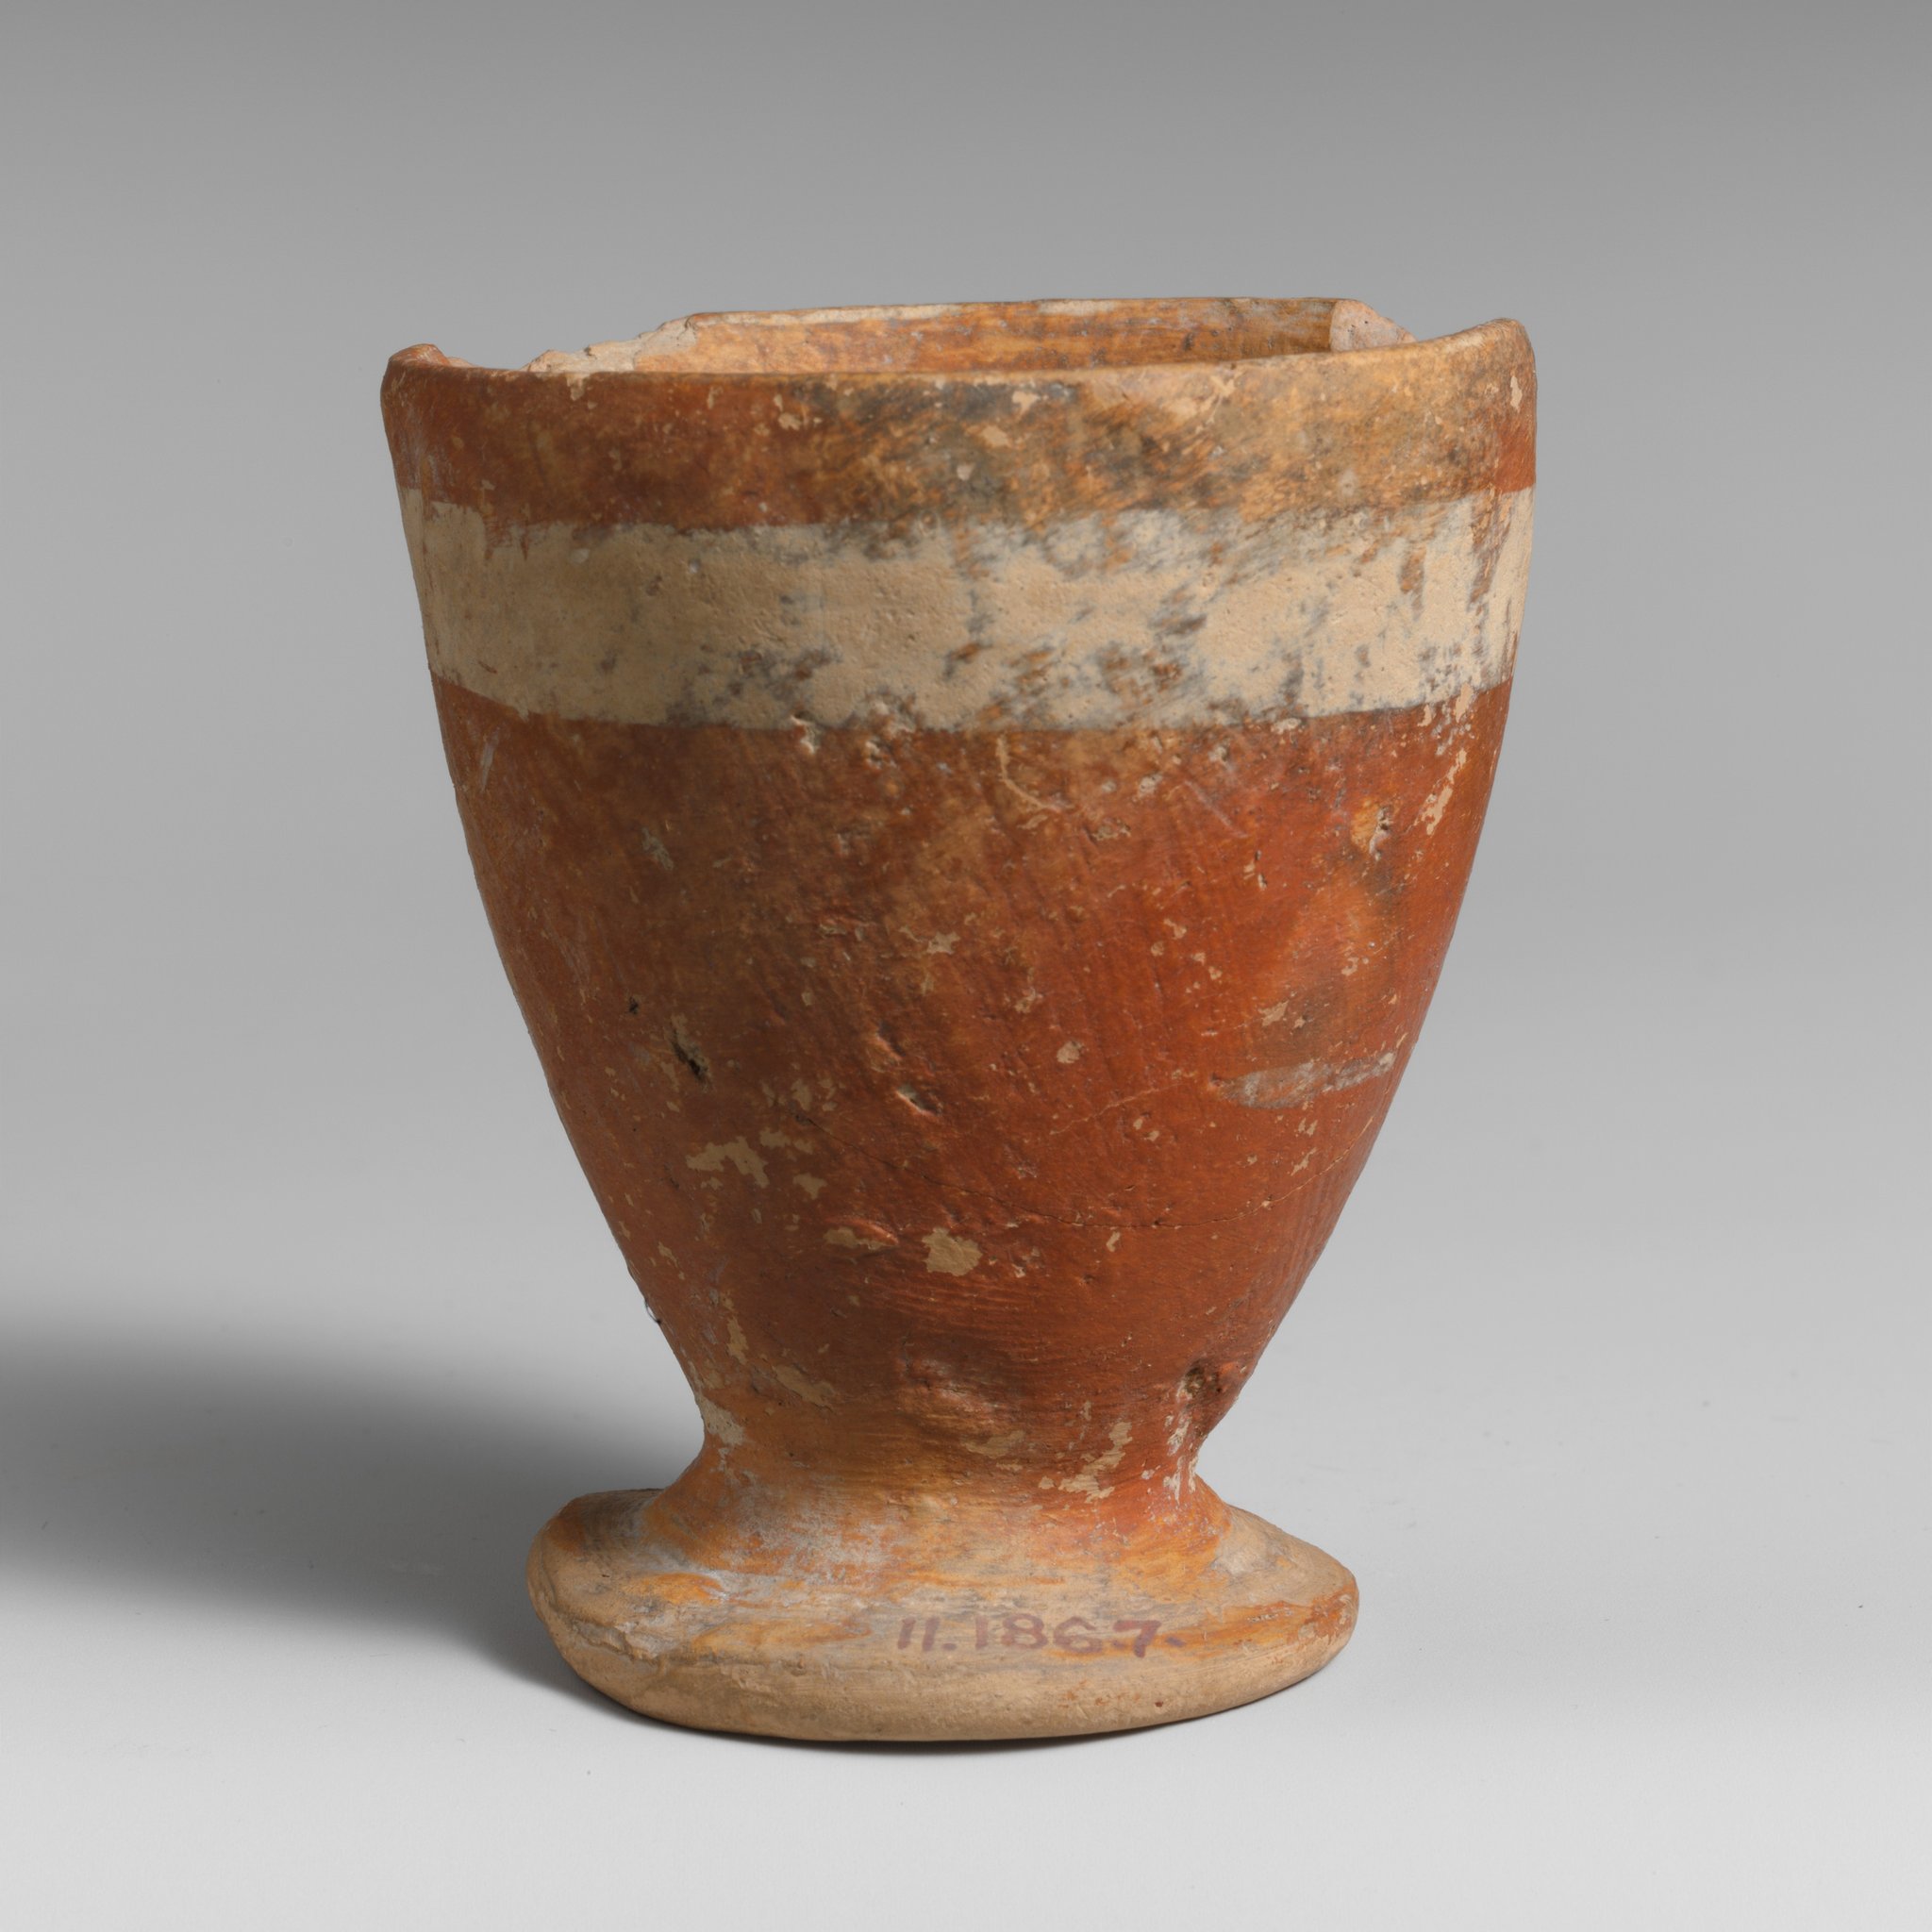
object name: cup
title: Terracotta goblet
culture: minoan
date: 2100-1900 BCE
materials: terracotta